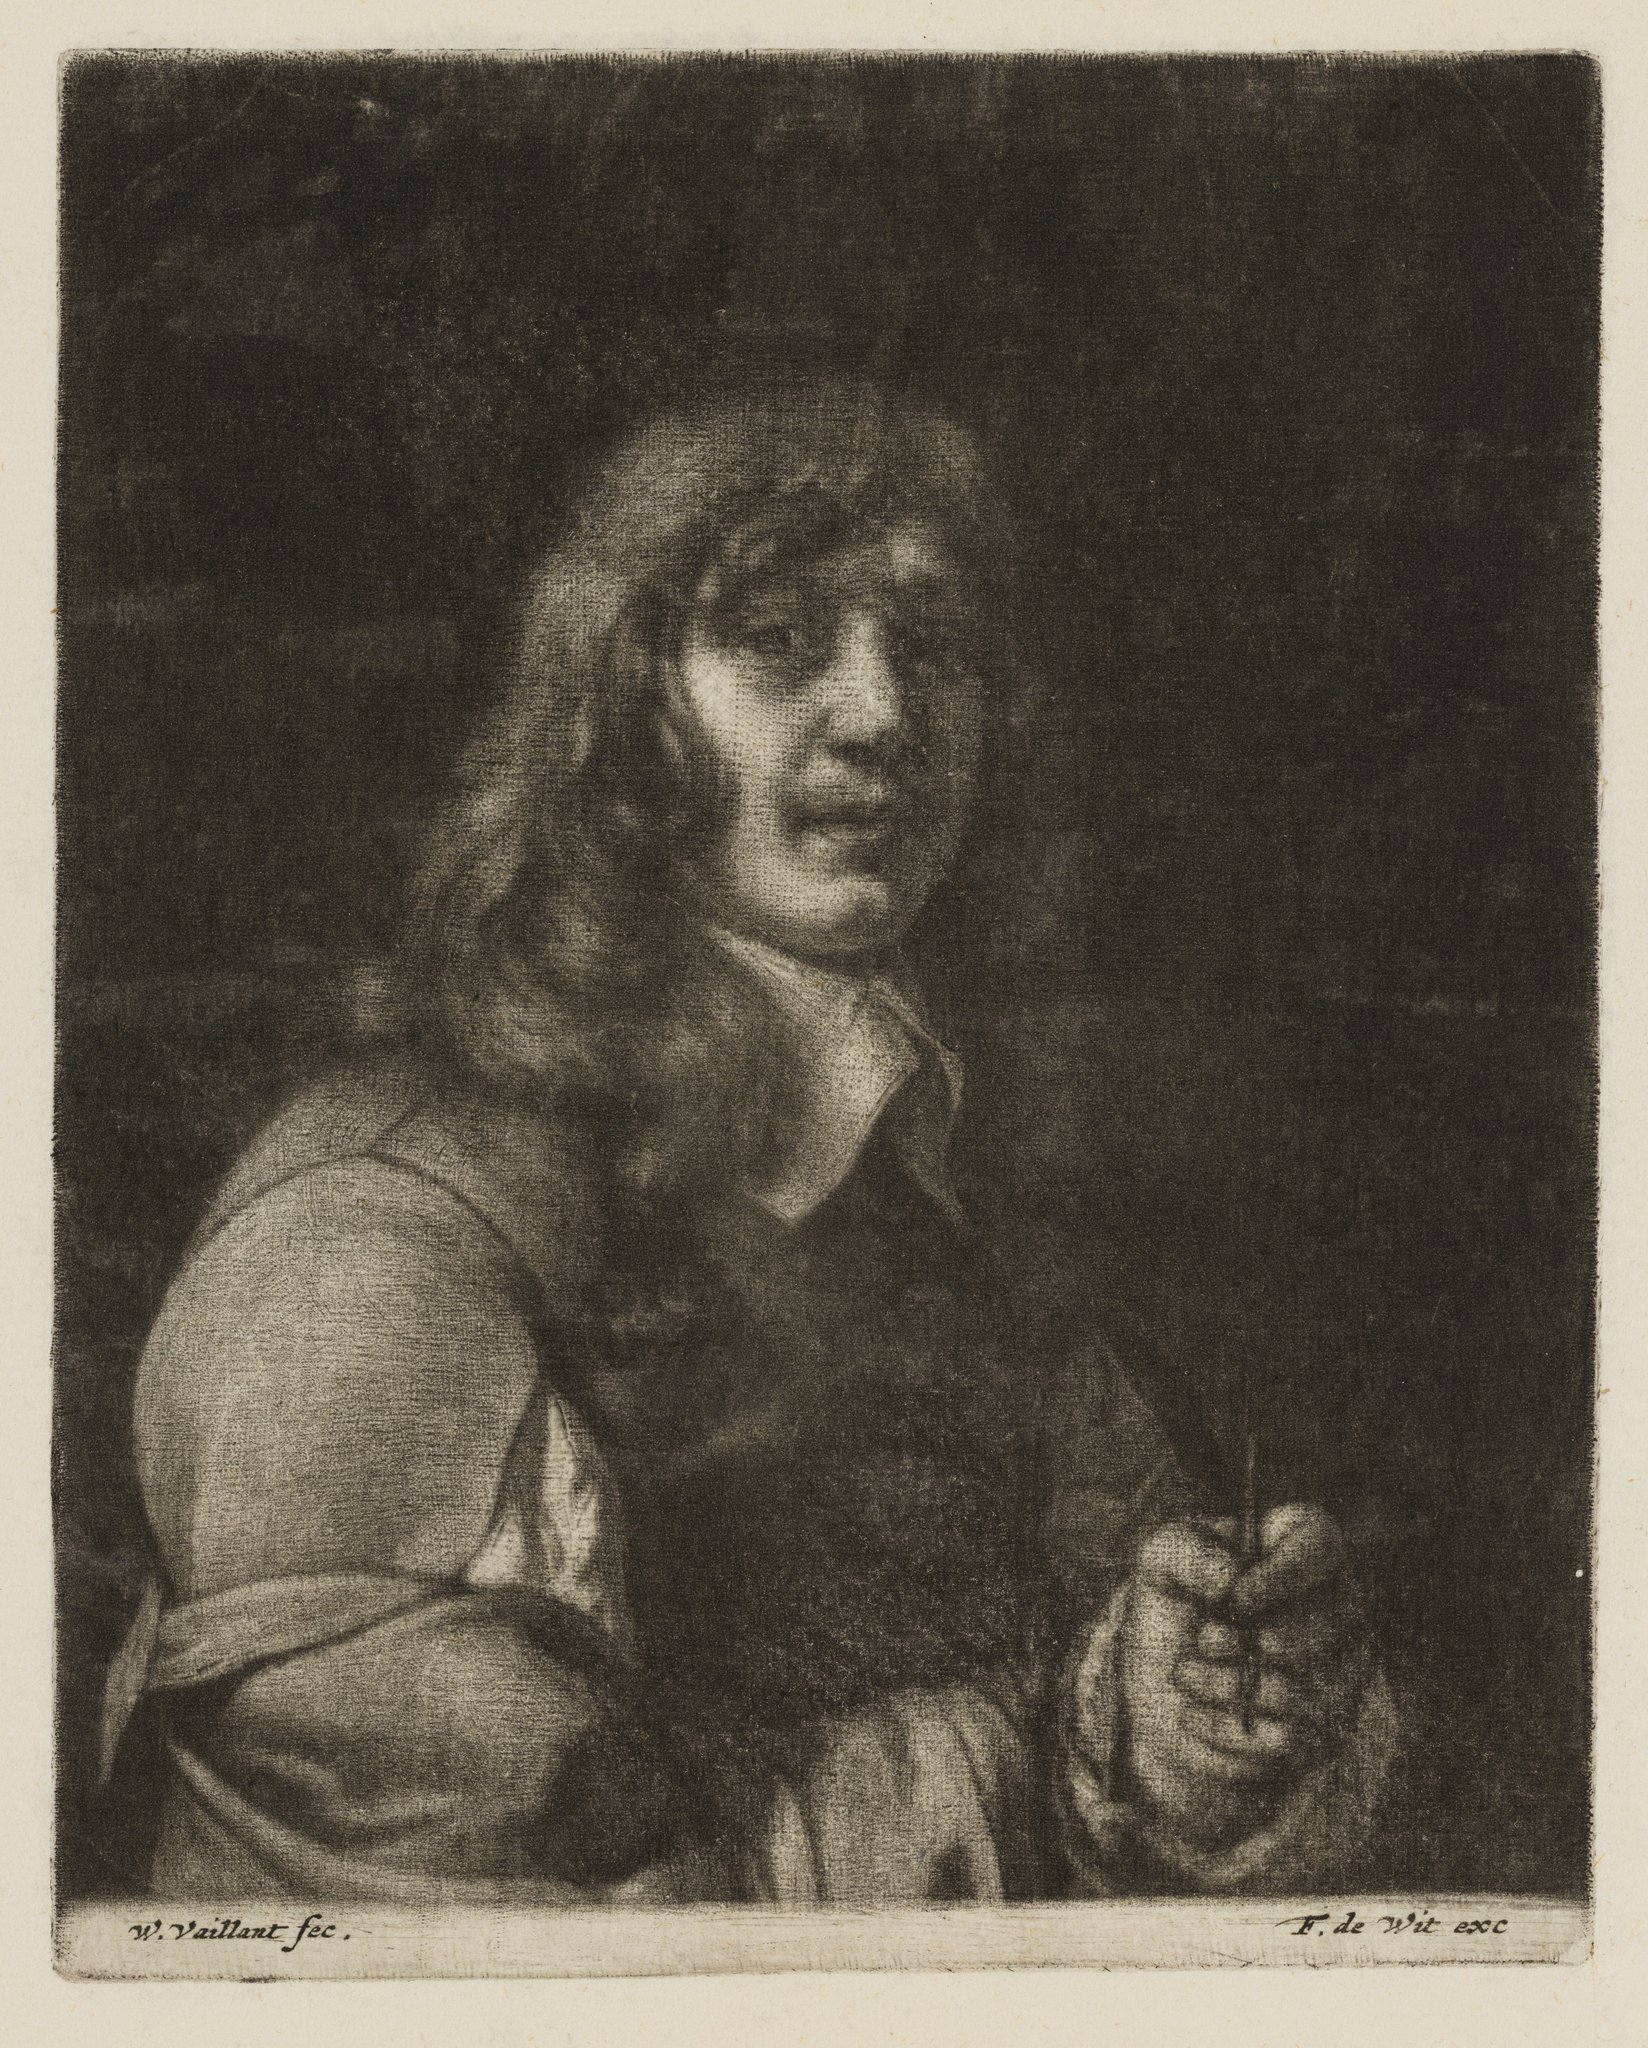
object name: print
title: Jacob van der Does, painter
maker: wallerant vaillant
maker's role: artist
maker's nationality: dutch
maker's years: 1623-1677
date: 1601-1700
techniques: mezzotint